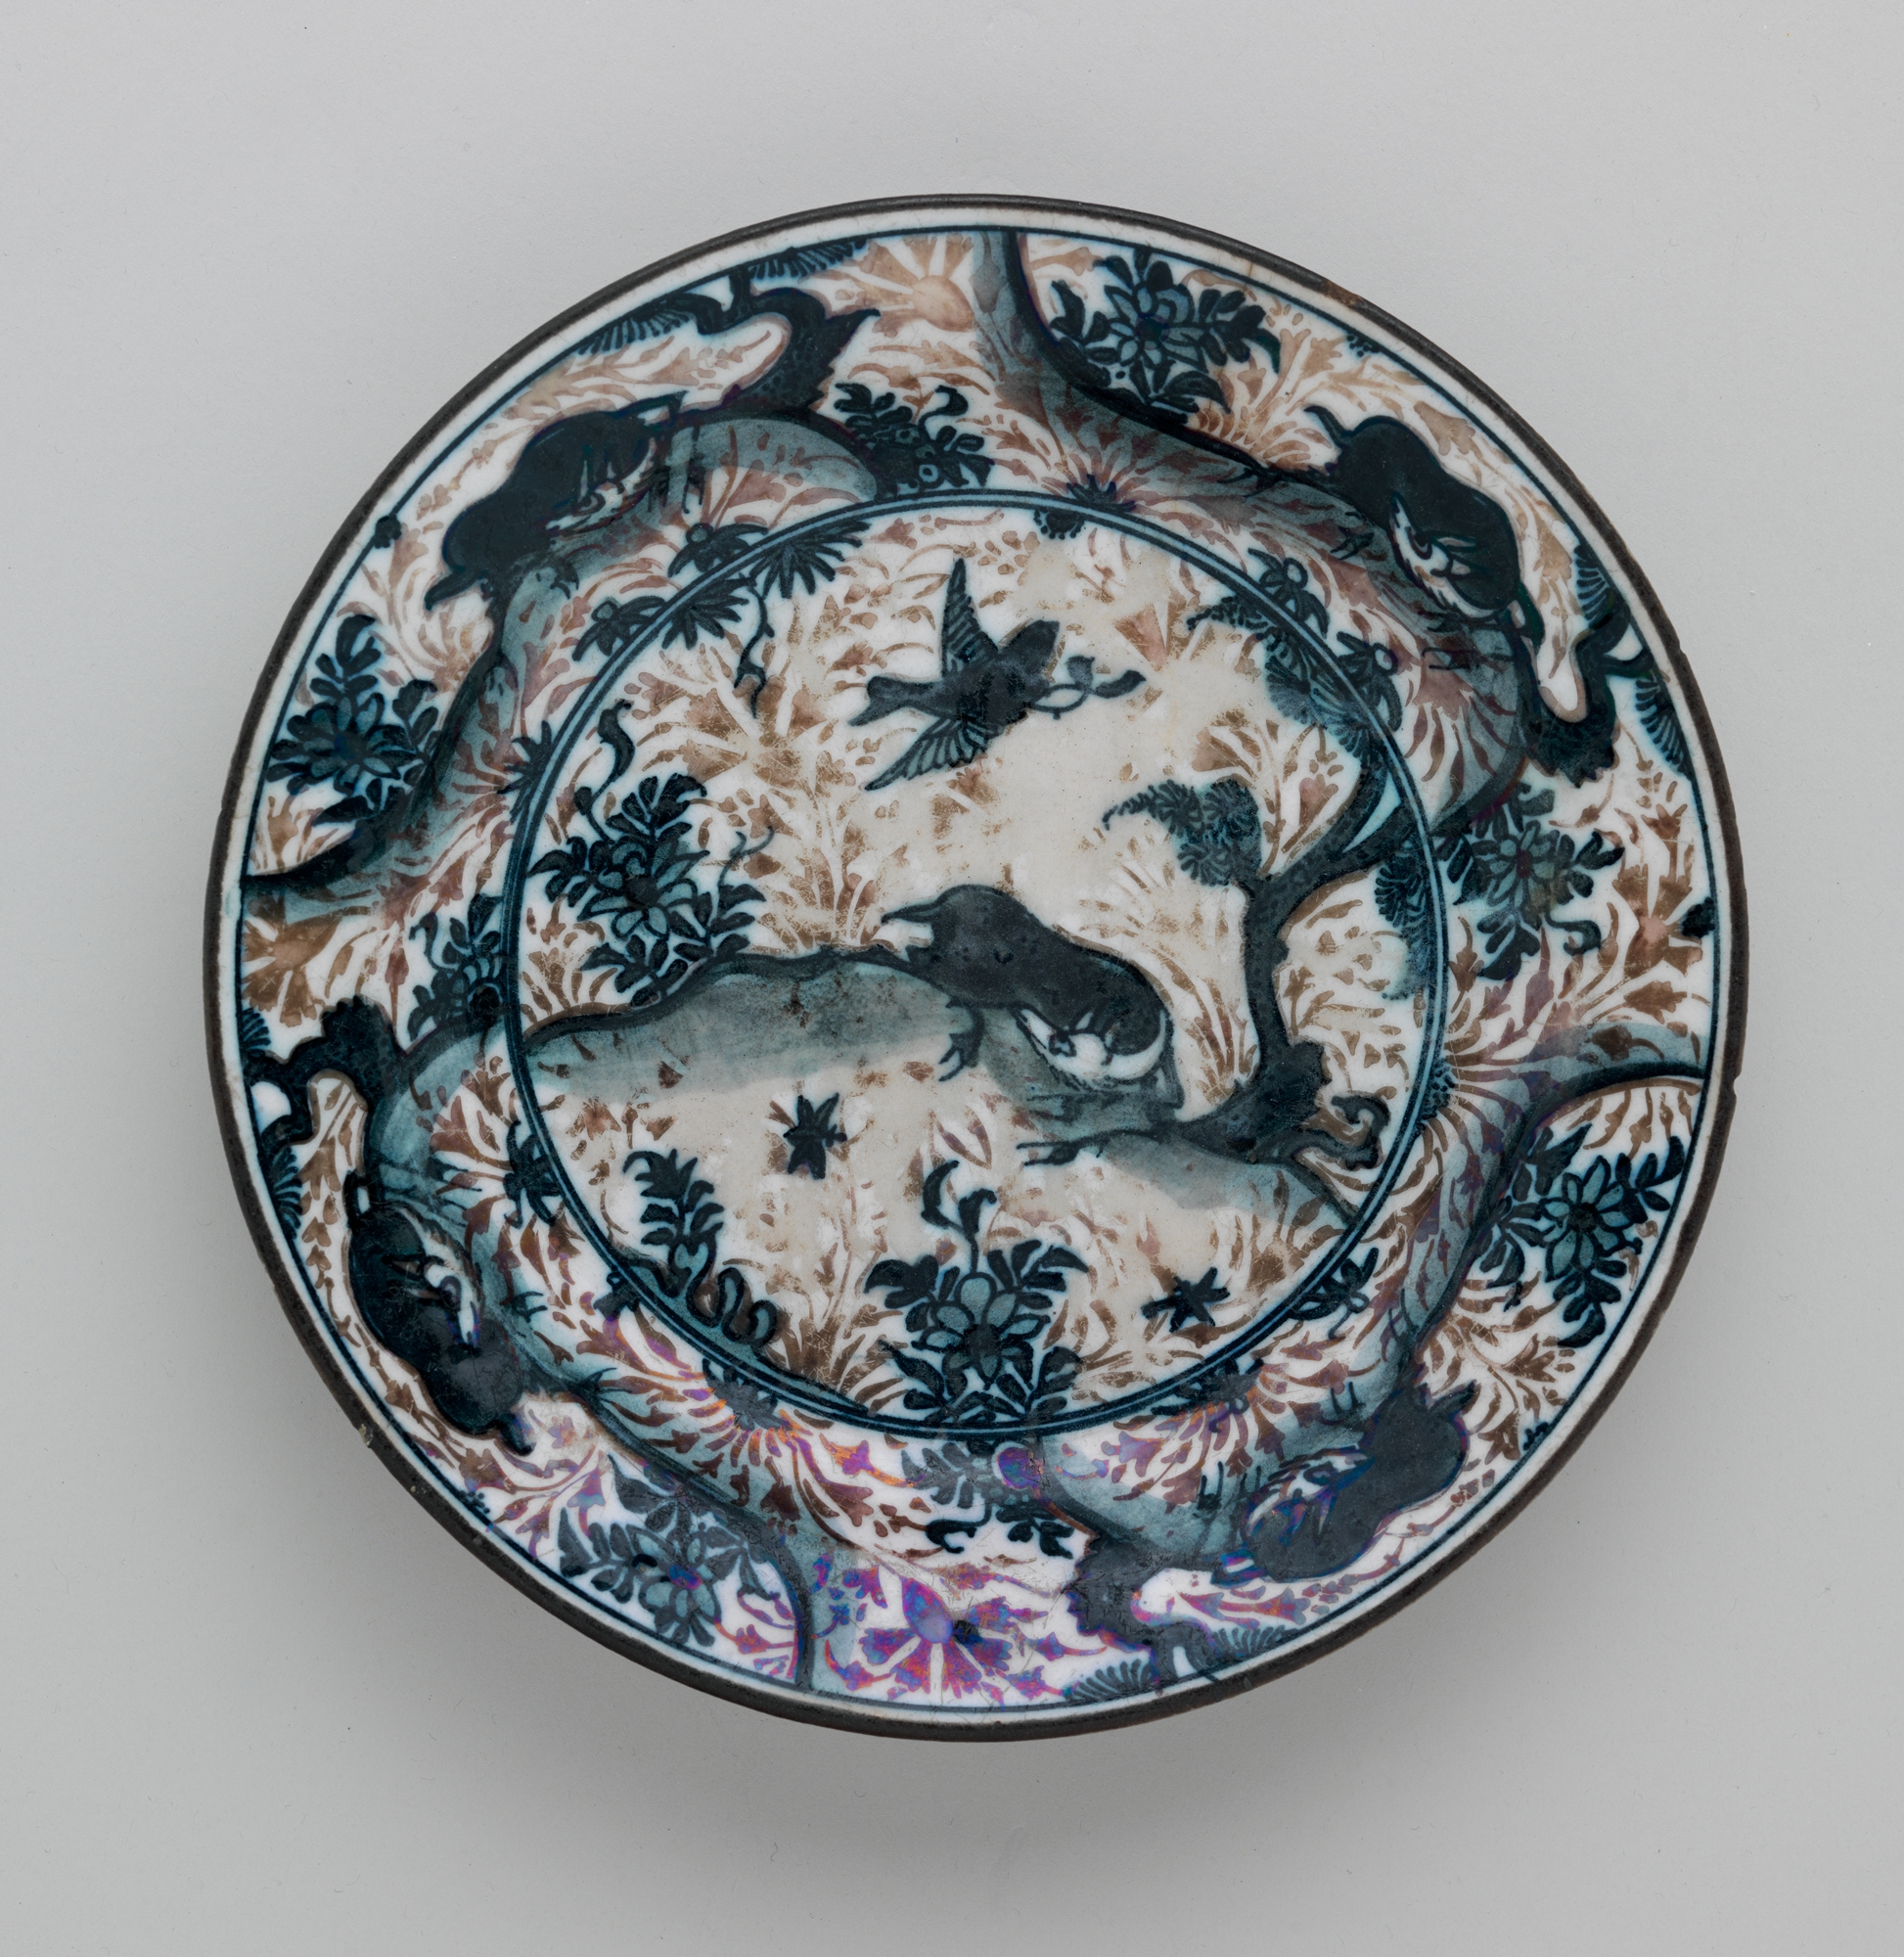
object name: dish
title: Plate Depicting Birds and Animals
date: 1601-1800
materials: glaze, stonepaste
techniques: painting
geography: iran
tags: animals,birds